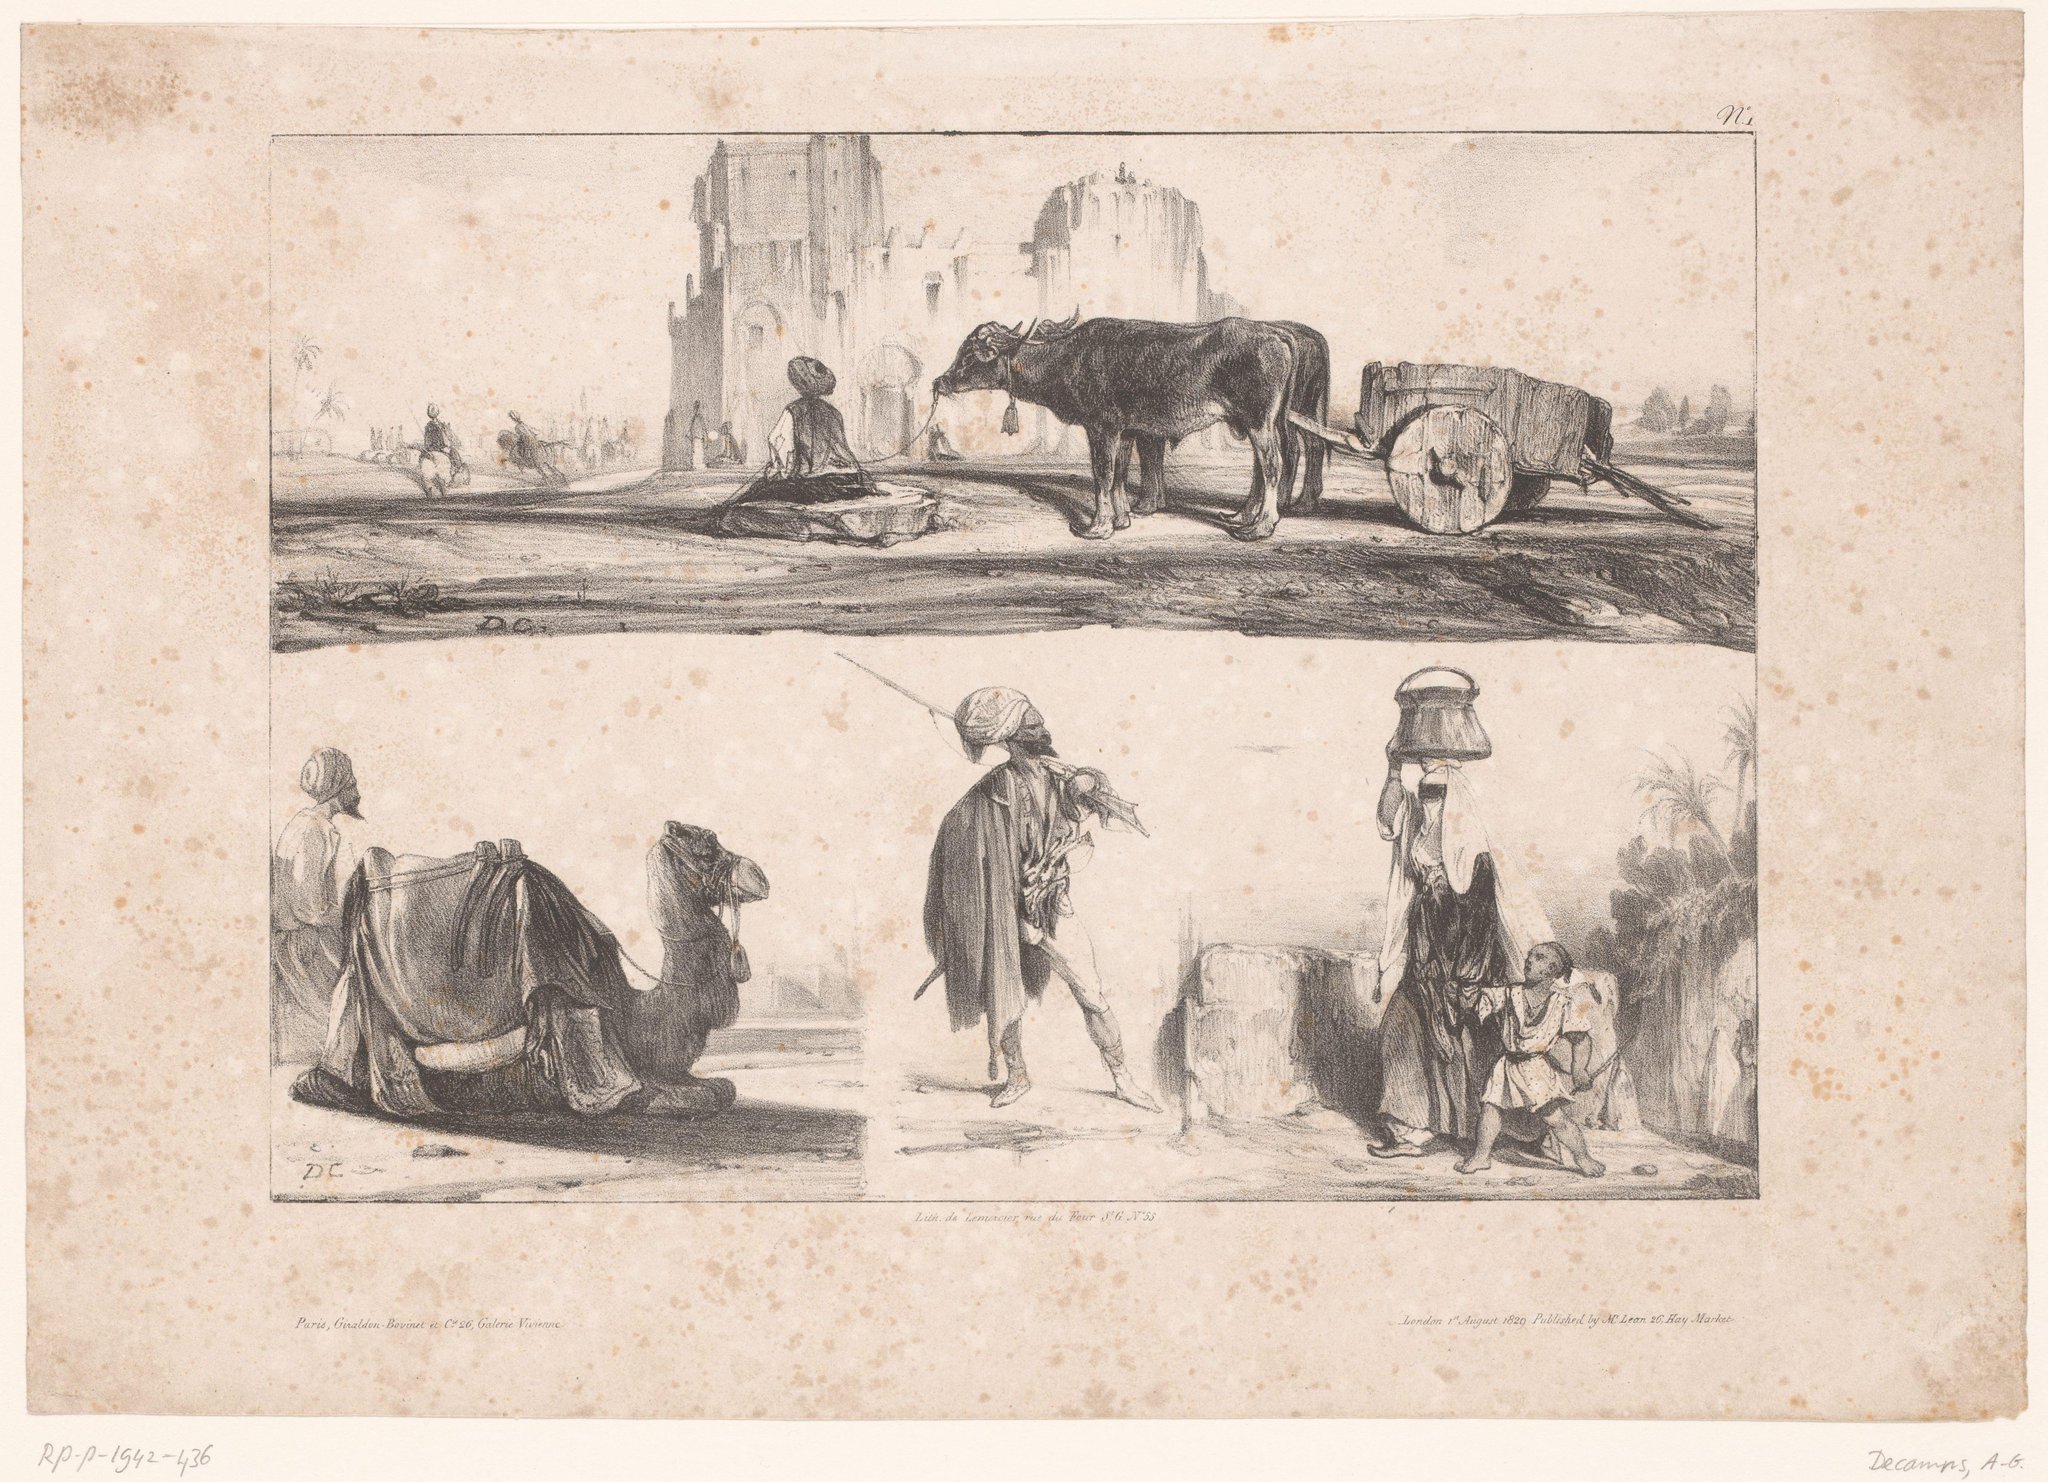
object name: print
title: Genrevoorstellingen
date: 1829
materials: paper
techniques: lithograph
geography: paris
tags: hoofed animals: dromedary, two-wheeled vehicle drawn by two animals, (farm) wagon, freight wagon, cart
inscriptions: collector's mark: Lugt 2228a, collector's mark: Lugt 2760, check stamp: Lugt 1138b